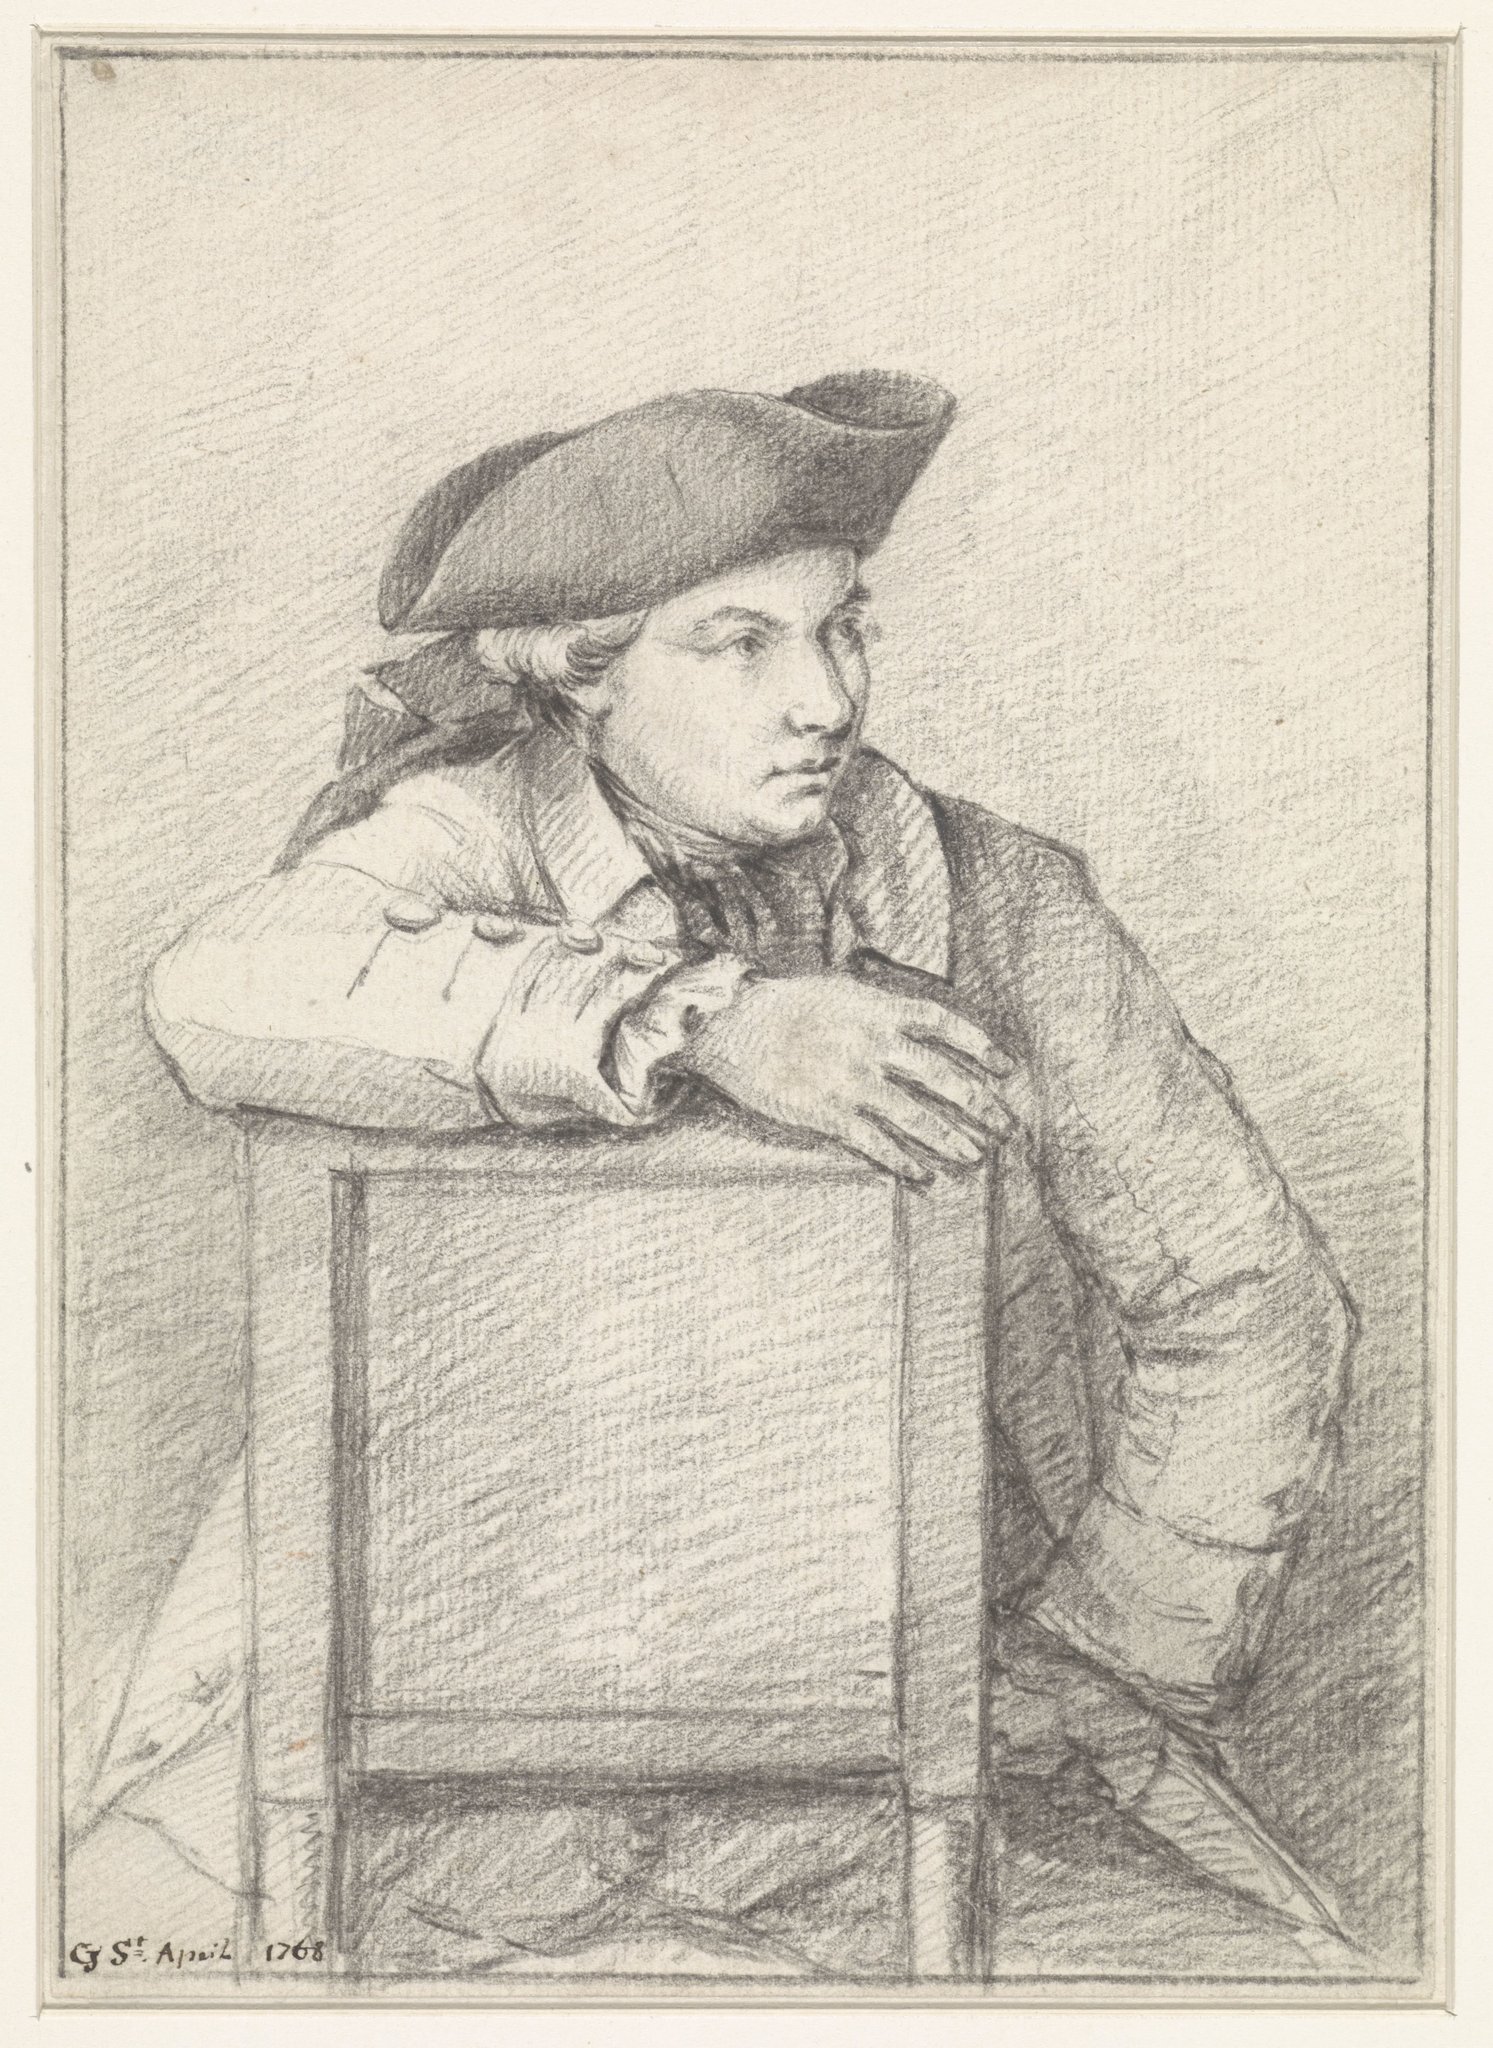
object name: drawing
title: Portret van Cornelis Buys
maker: guillaume saint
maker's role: draughtsman, print maker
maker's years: 1730-1780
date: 1768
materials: chalk, paper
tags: amsterdam, cornelis buys, historical persons, portrait, self-portrait of painter, portrait, self-portrait of artist, portrait, self-portrait of draughtsman